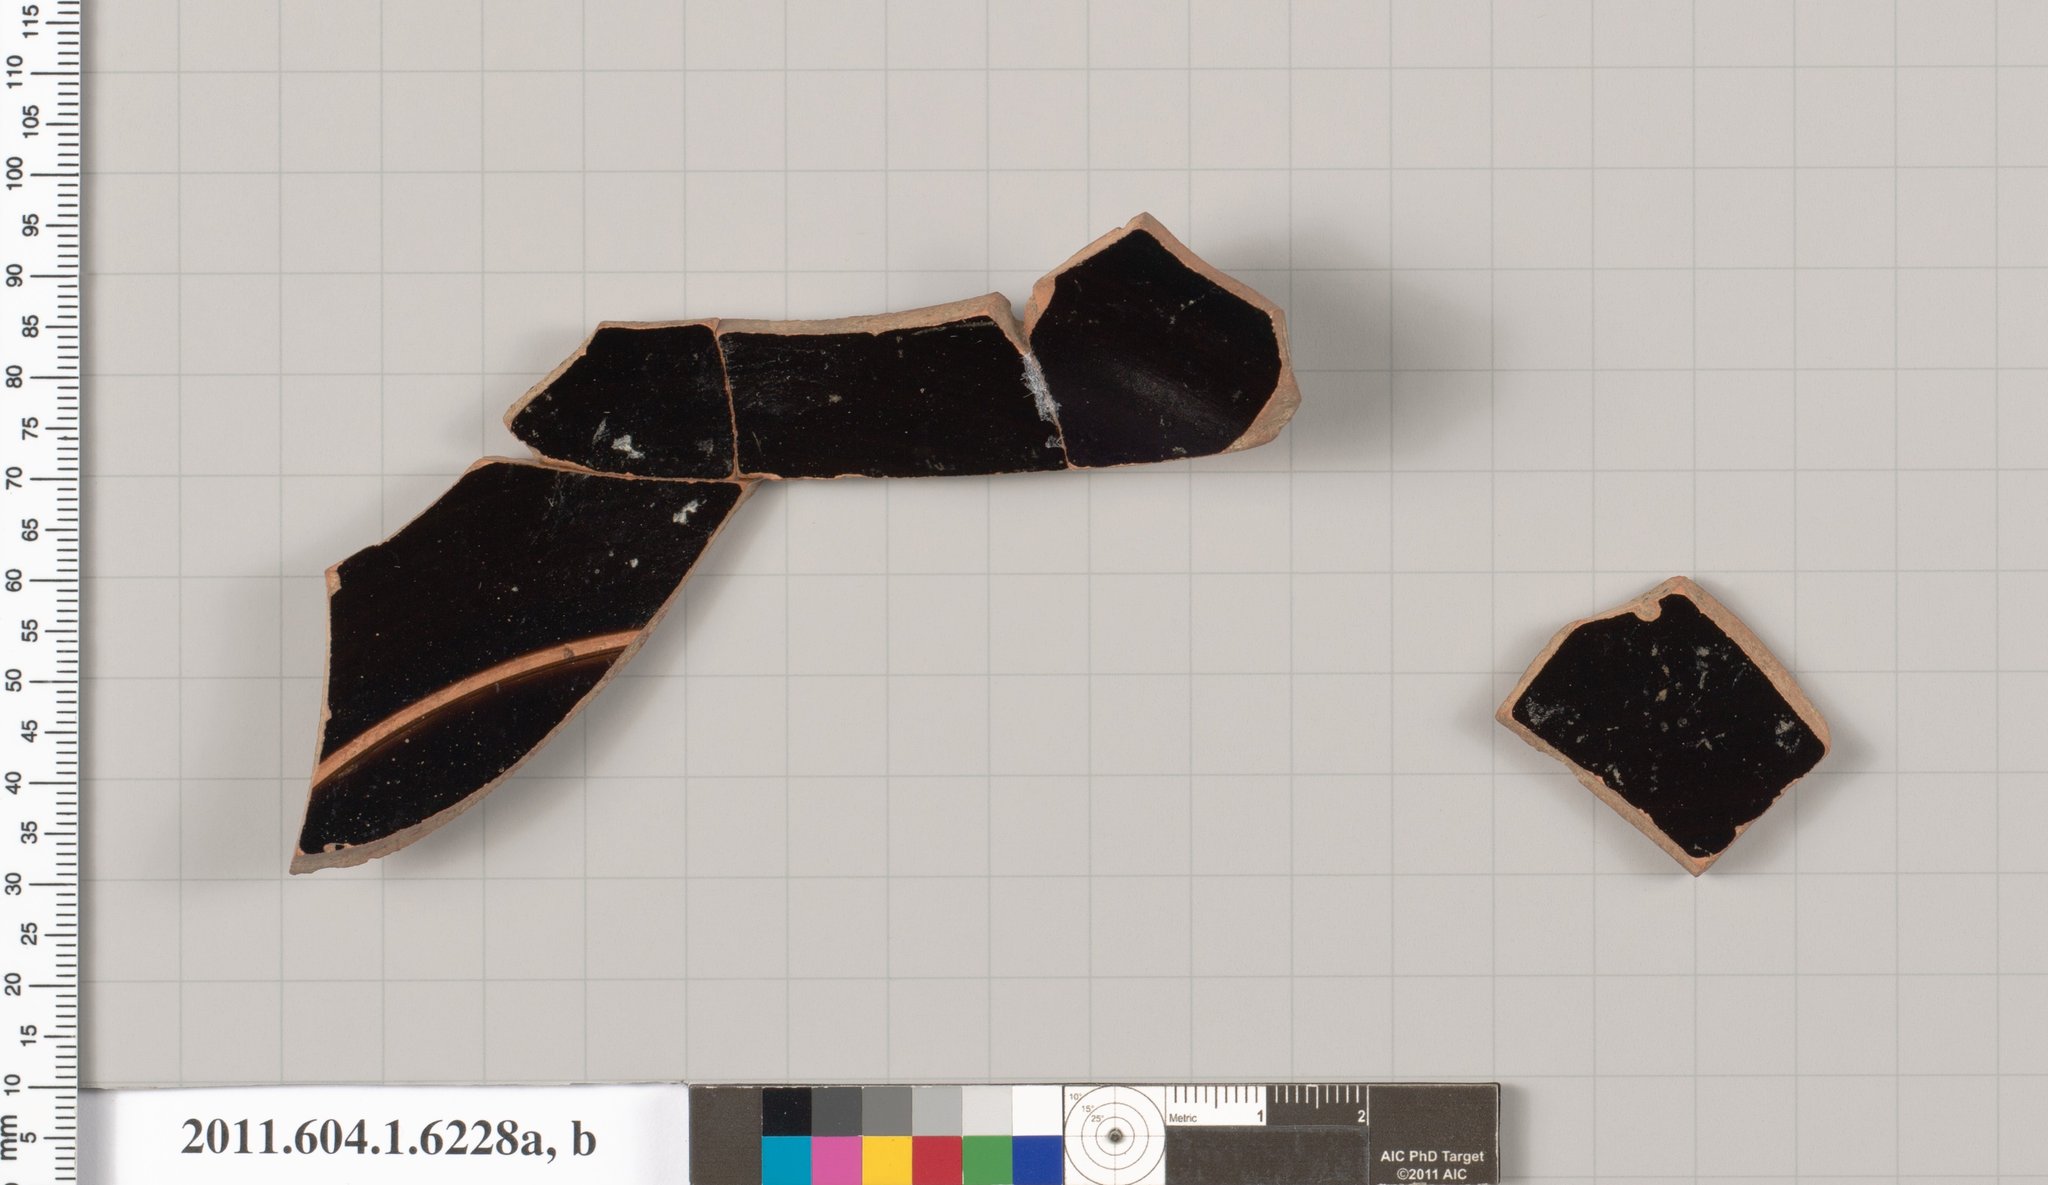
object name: kylix fragment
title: Terracotta fragments of a kylix (drinking cup)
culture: greek, attic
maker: thorvaldsen group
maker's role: artist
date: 520-500 BCE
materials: terracotta